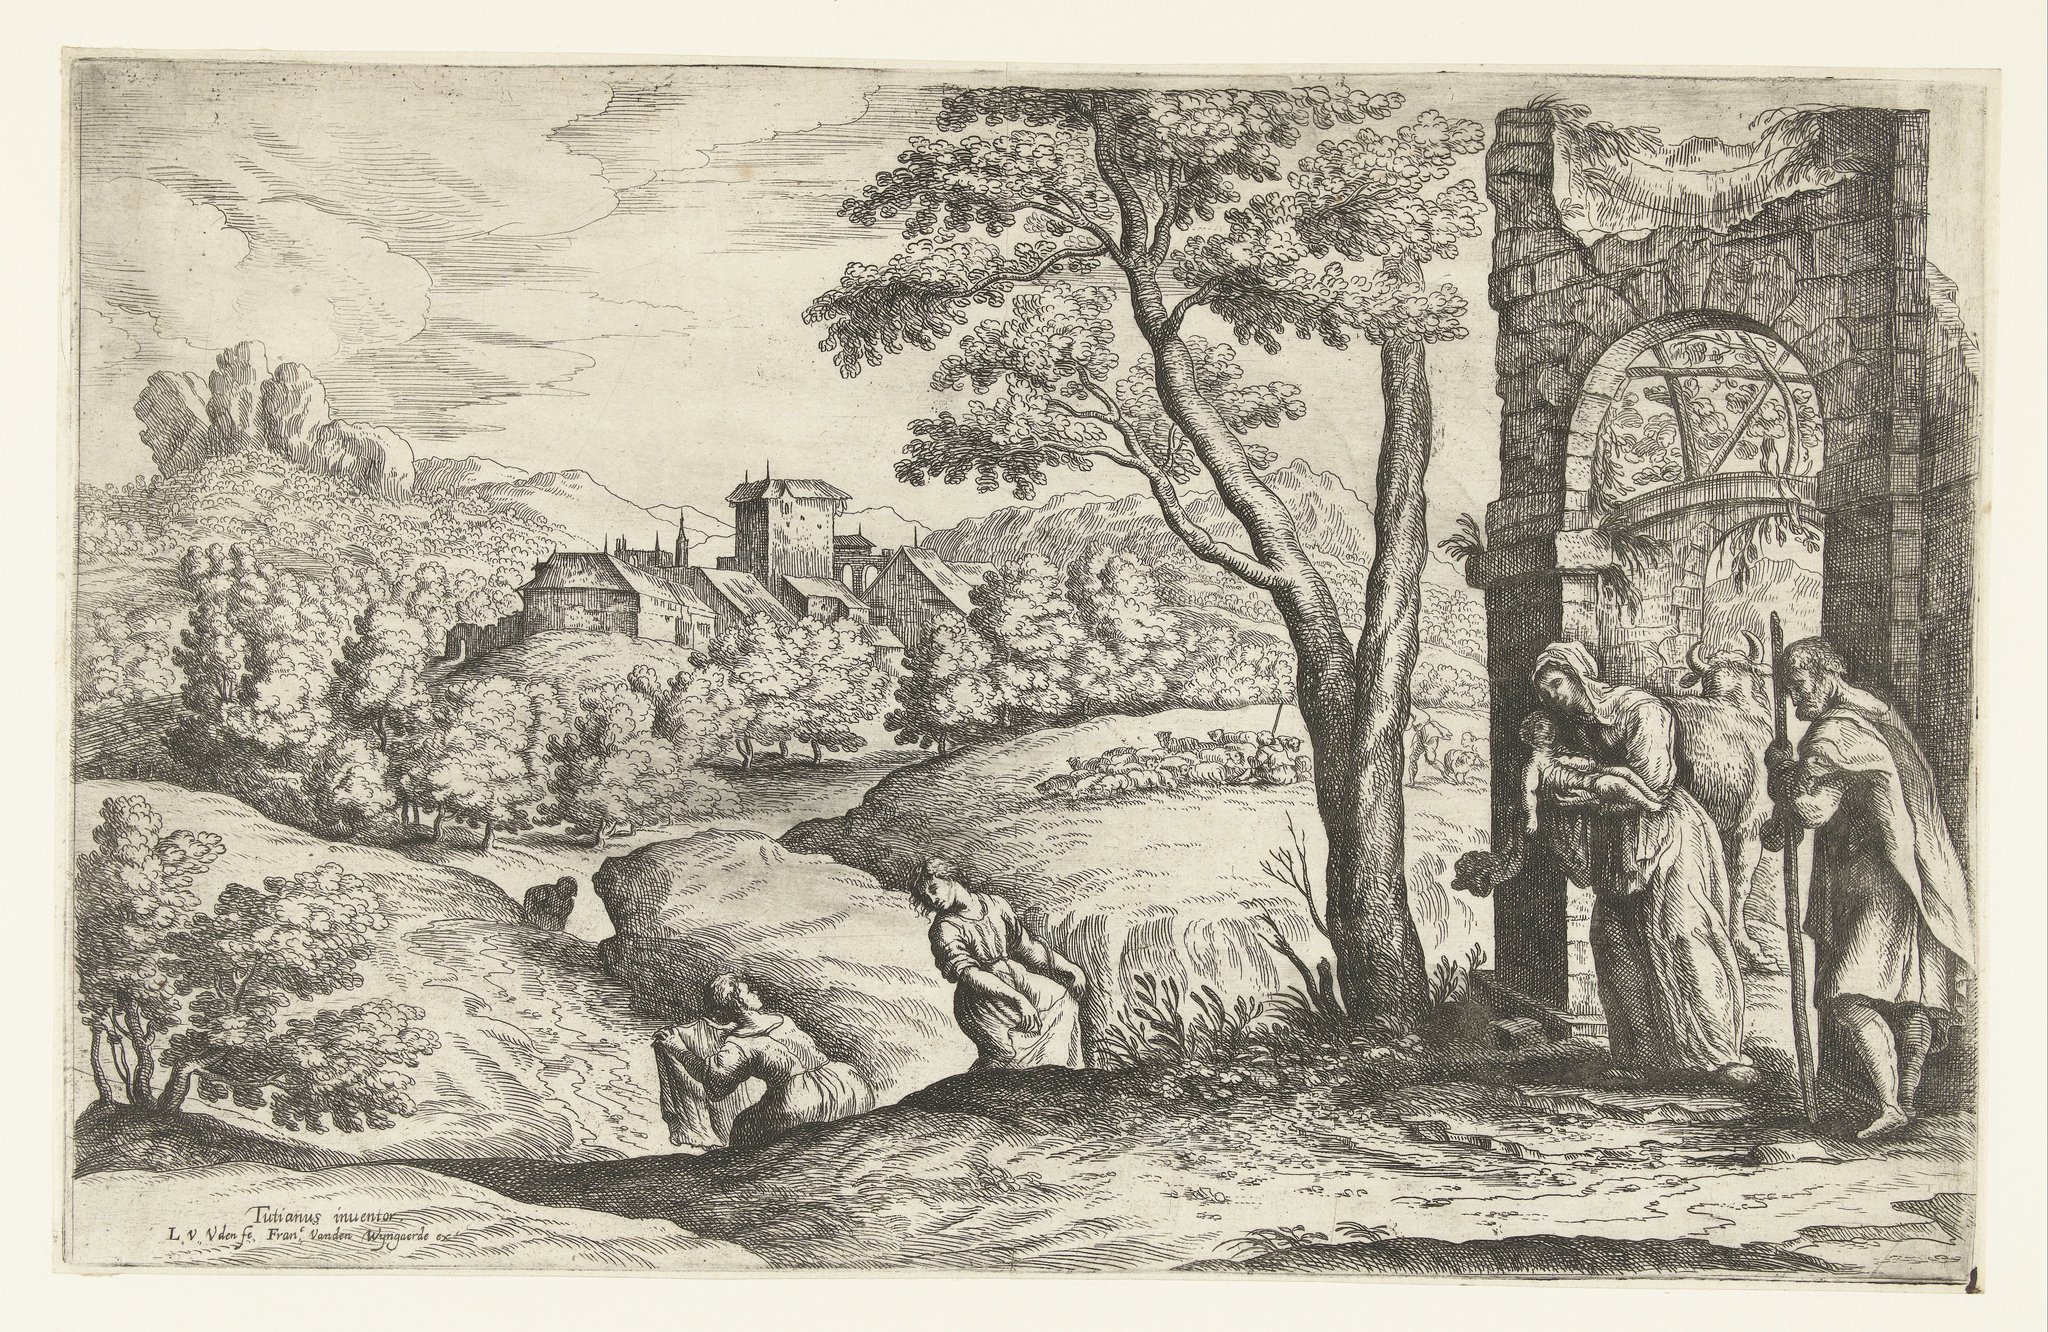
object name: print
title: Landschap met de heilige familie en twee voedvrouwen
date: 1605-1673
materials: paper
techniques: engraving, etching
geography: low countries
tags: midwife, 'accoucheuse', mary, joseph and the new-born christ (nativity)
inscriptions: collector's mark: Lugt 11, number: ‘1’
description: Landschap met een ruïne met Maria, het Christuskind, Jozef en de os. Twee vrouwen wassen lakens in een beek.